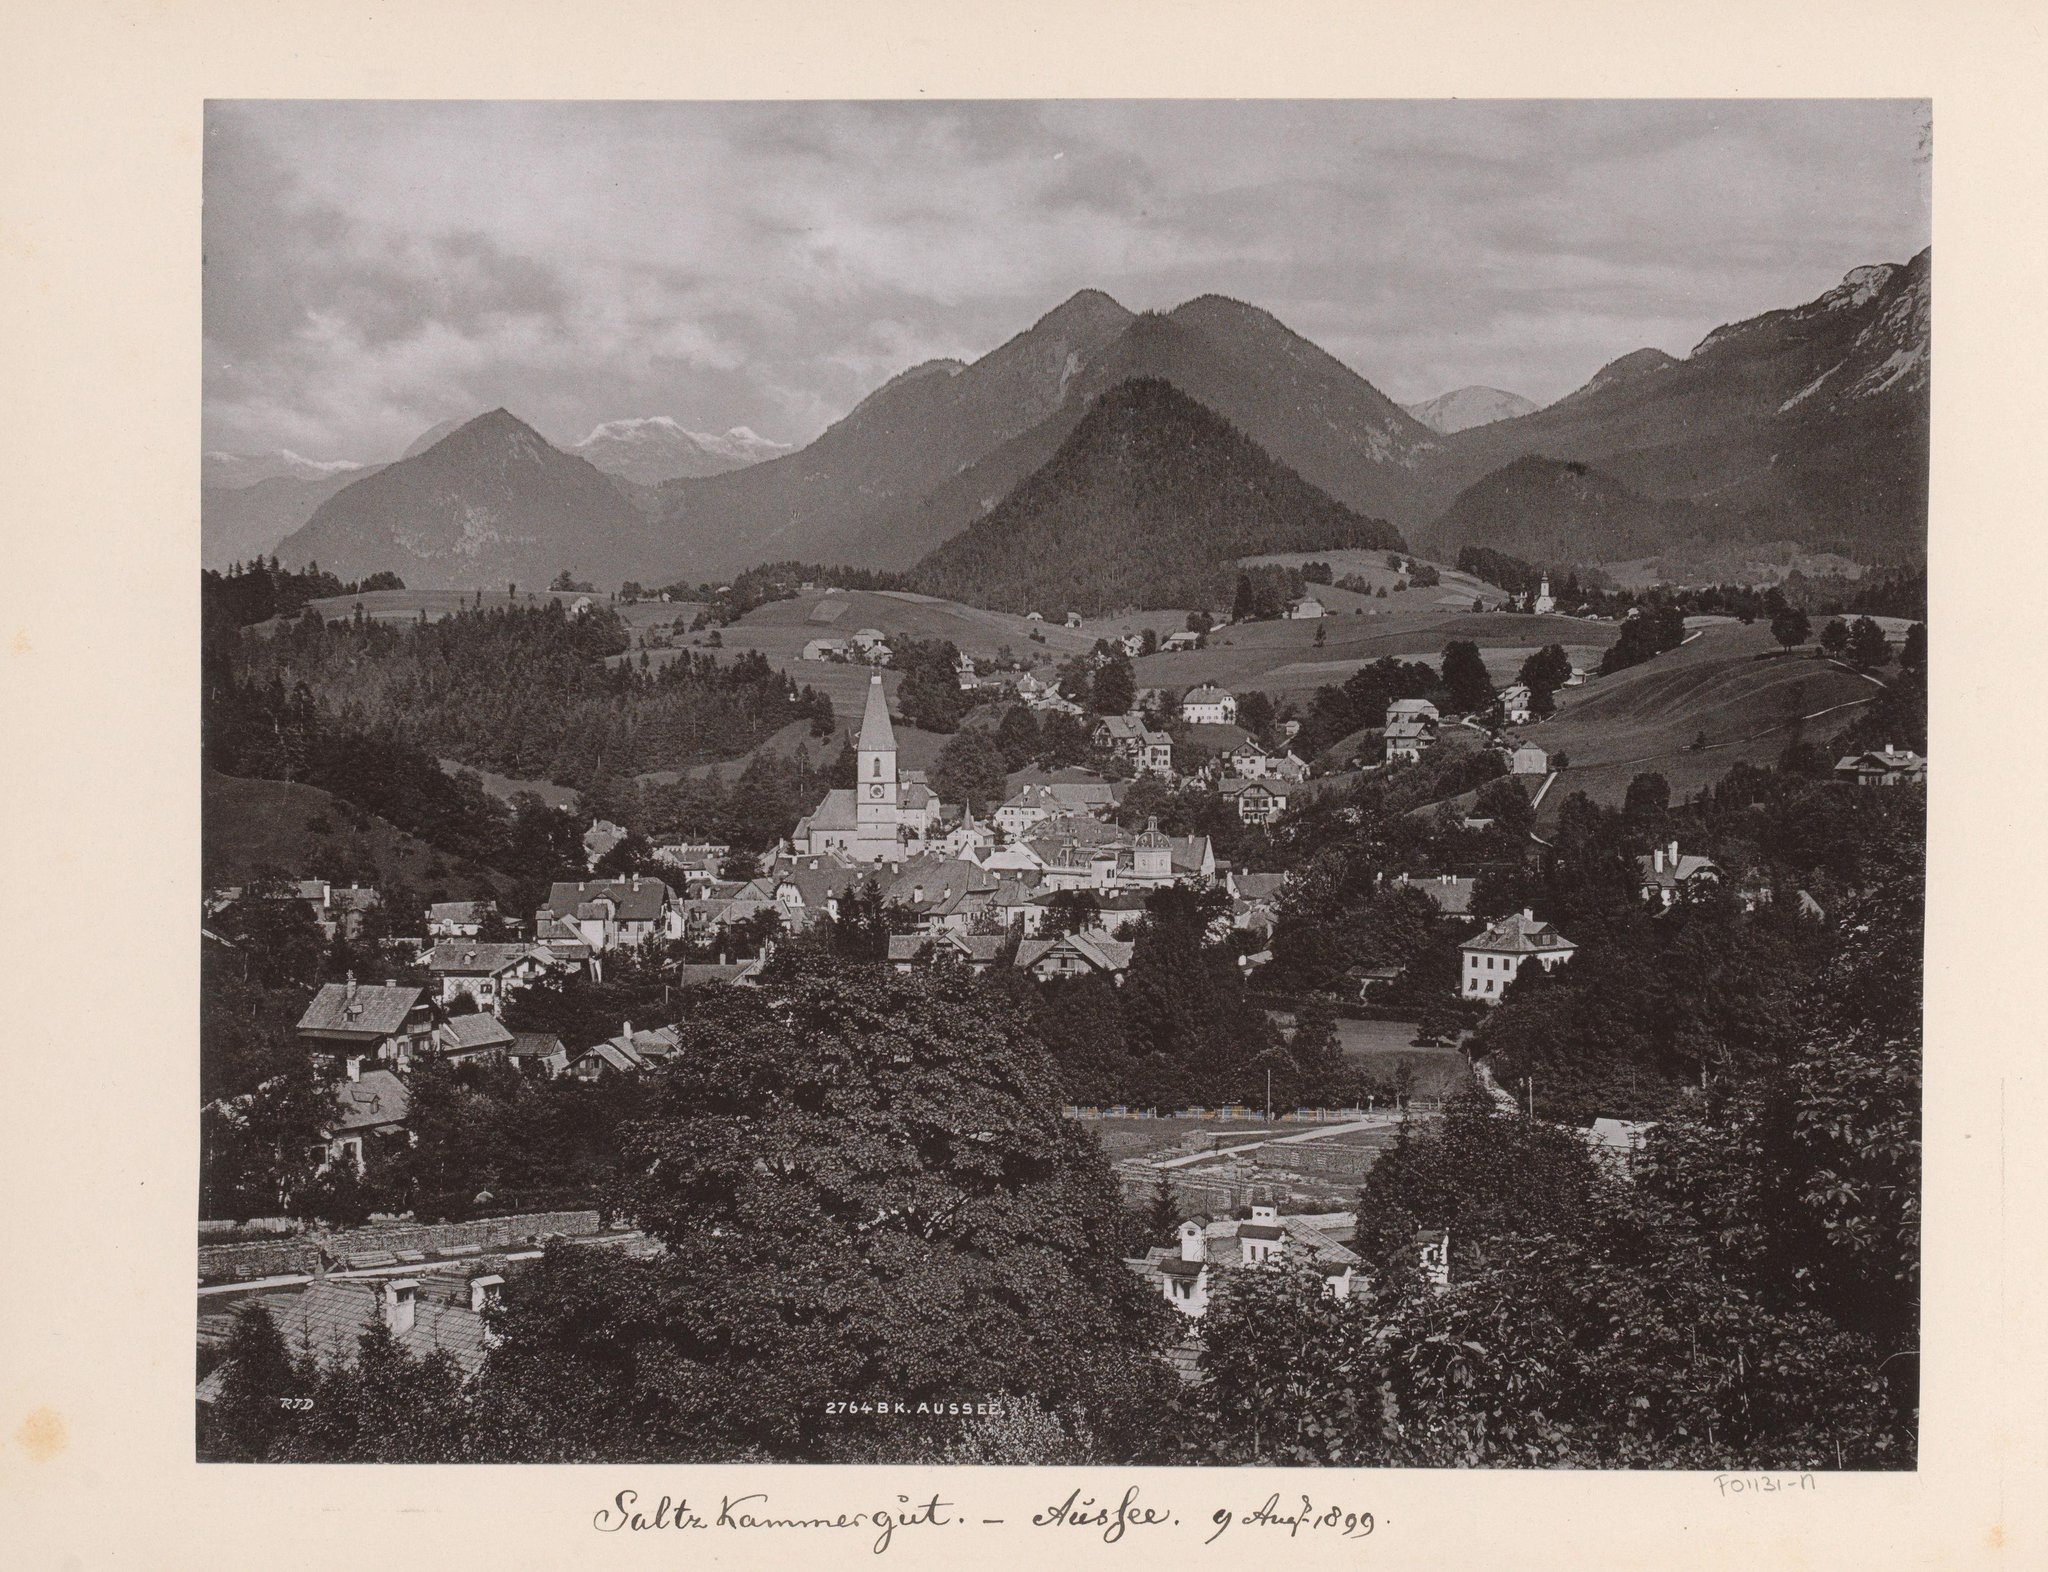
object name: album leaf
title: Aussee.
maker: Anonymous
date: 1880-1899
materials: paper, photographic support, ink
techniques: photograph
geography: bad aussee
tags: prospect of village, silhouette of village, mountains (+ landscape with figures, staffage)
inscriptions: number: ‘2764’, inscription: ‘RJD’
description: Onderdeel van Reisalbum met bezienswaardigheden in Duitsland, Oostenrijk, Zwitserland, Luxemburg en België.